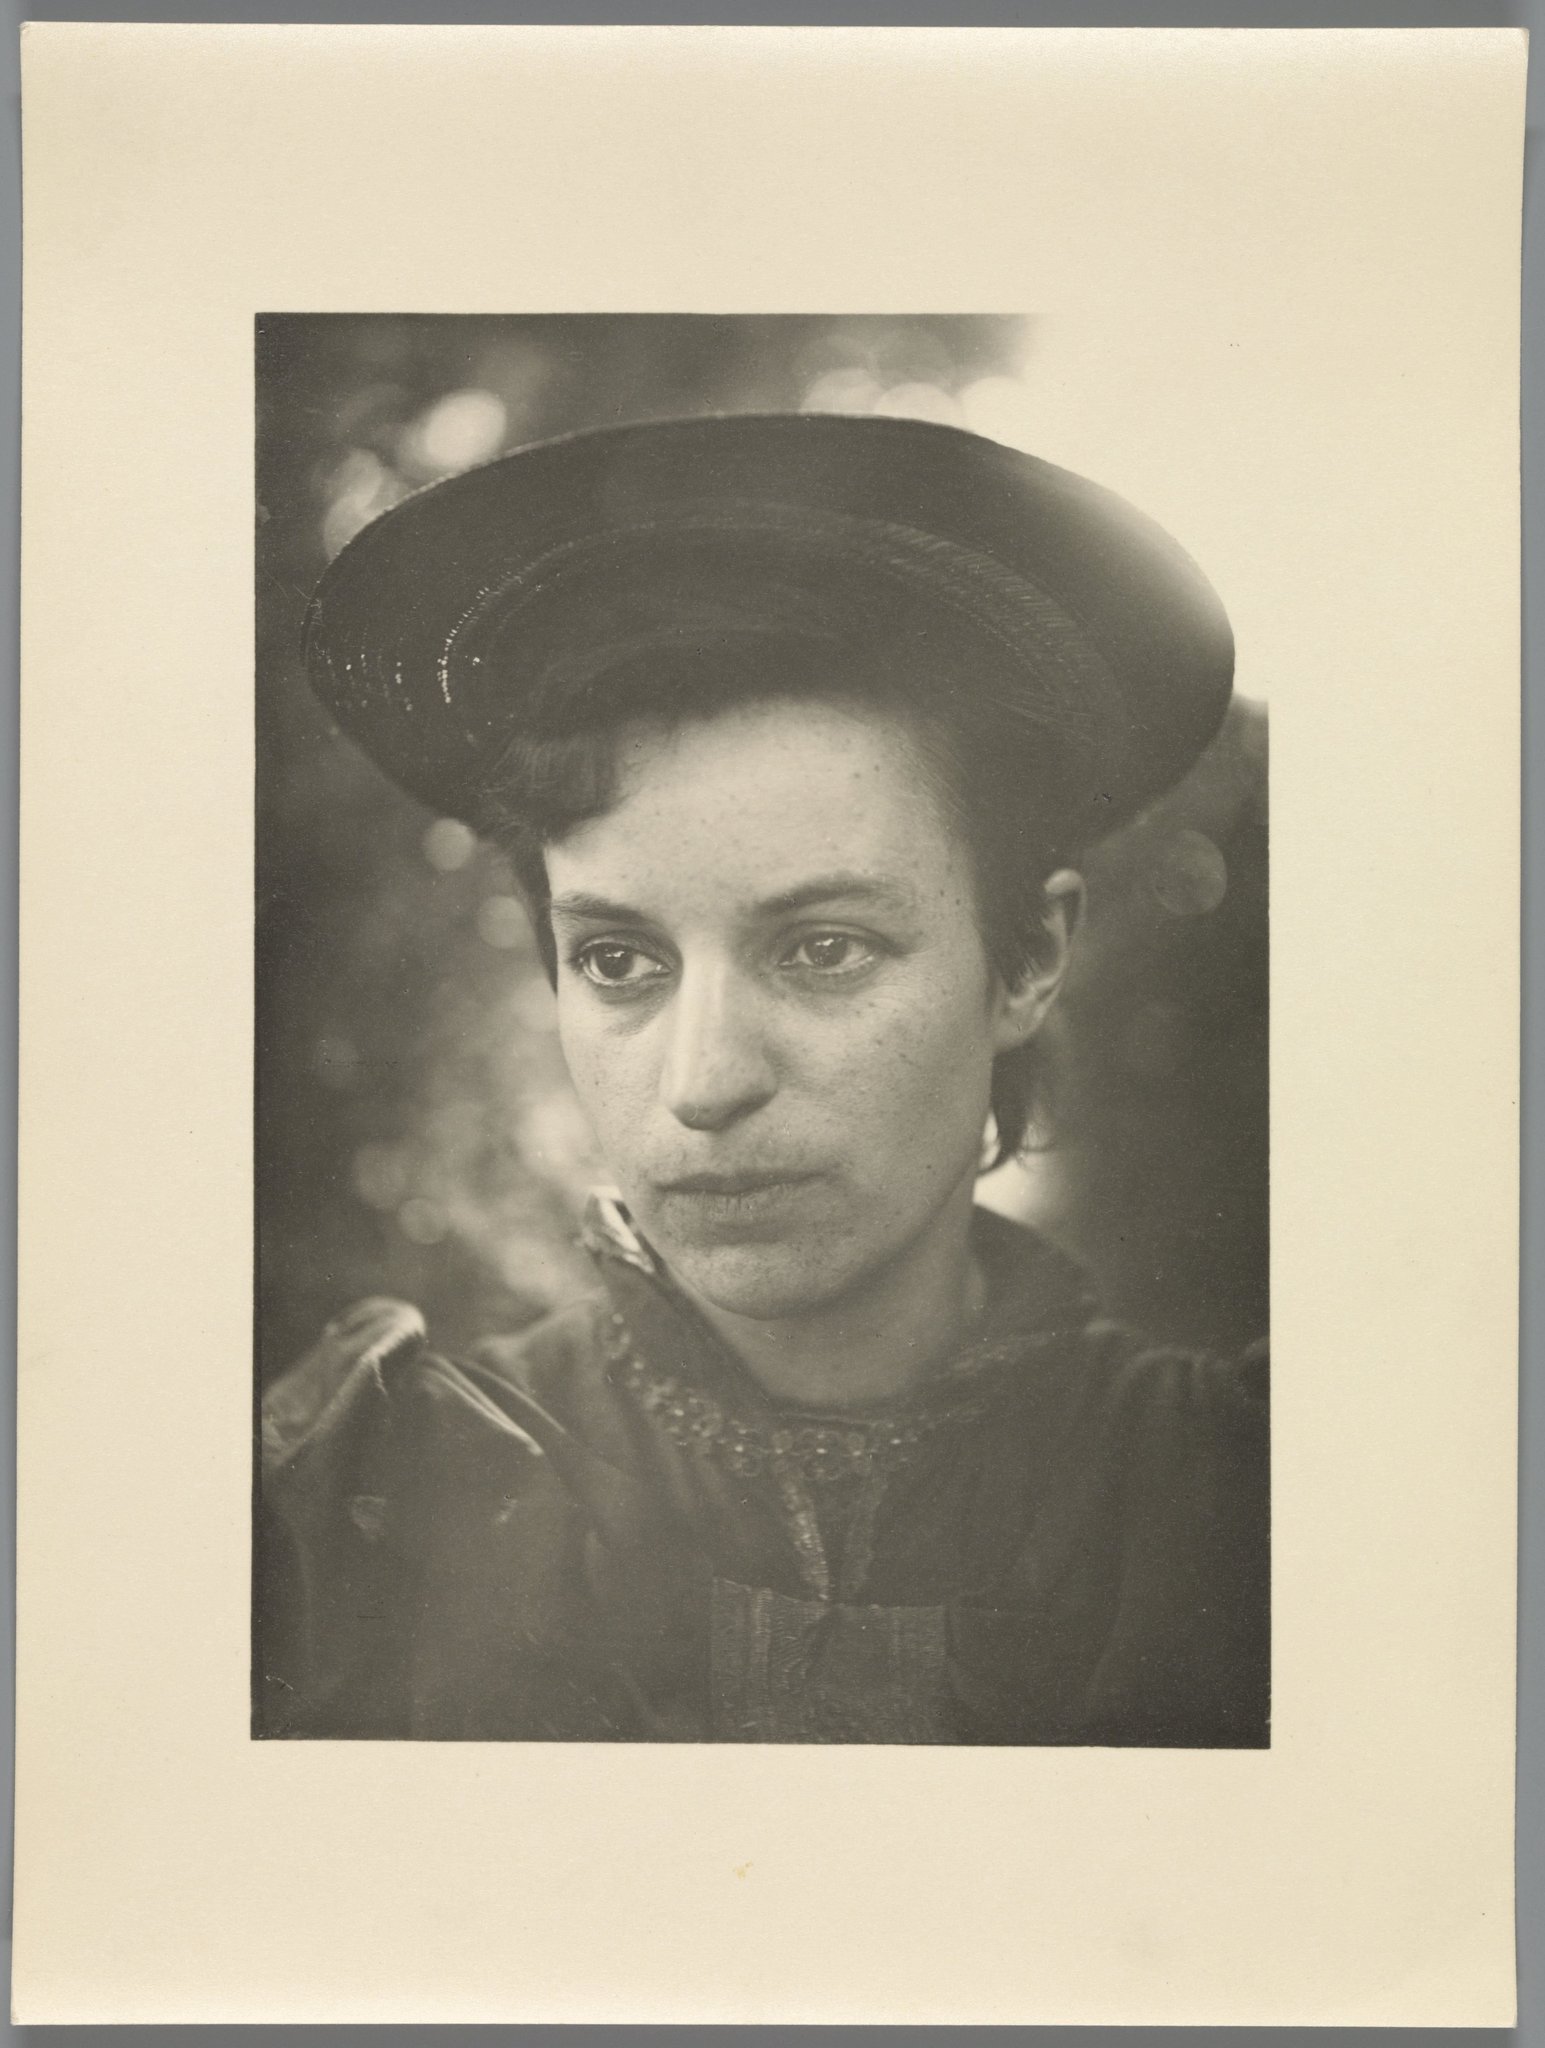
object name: photograph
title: Reproductie naar een foto van Willem Witsen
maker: Anonymous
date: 1860-1915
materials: paper, photographic support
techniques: gelatin silver print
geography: netherlands